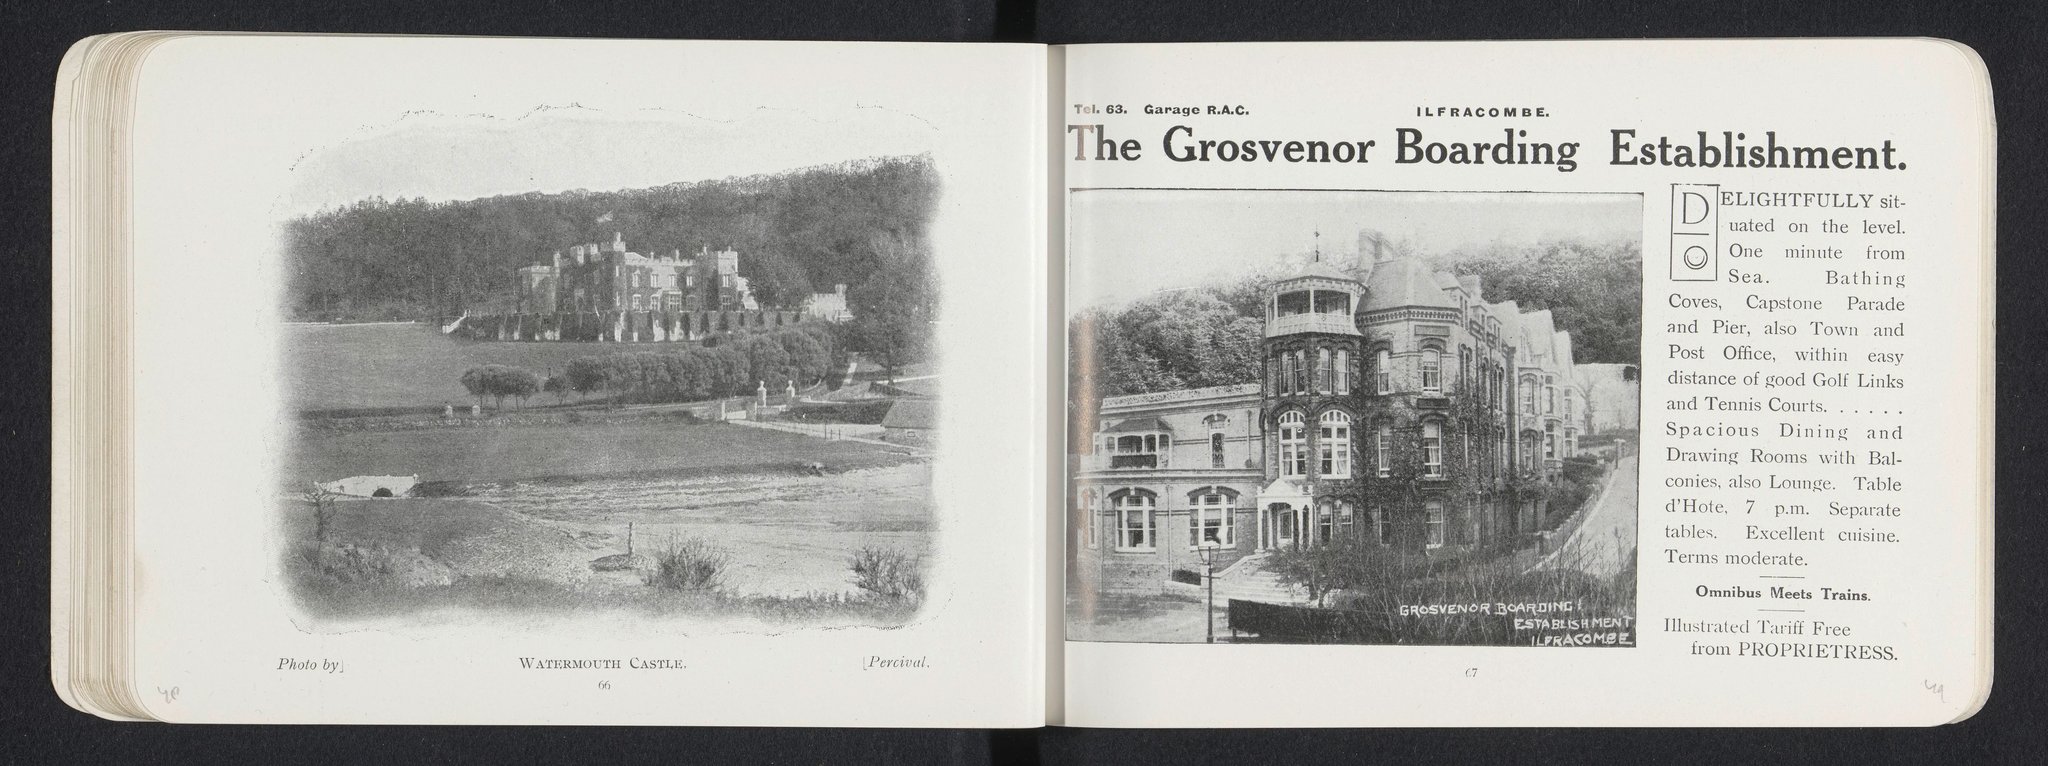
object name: page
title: Watermouth Castle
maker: Anonymous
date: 1900-1920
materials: paper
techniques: autotype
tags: castle, façade (of house or building)